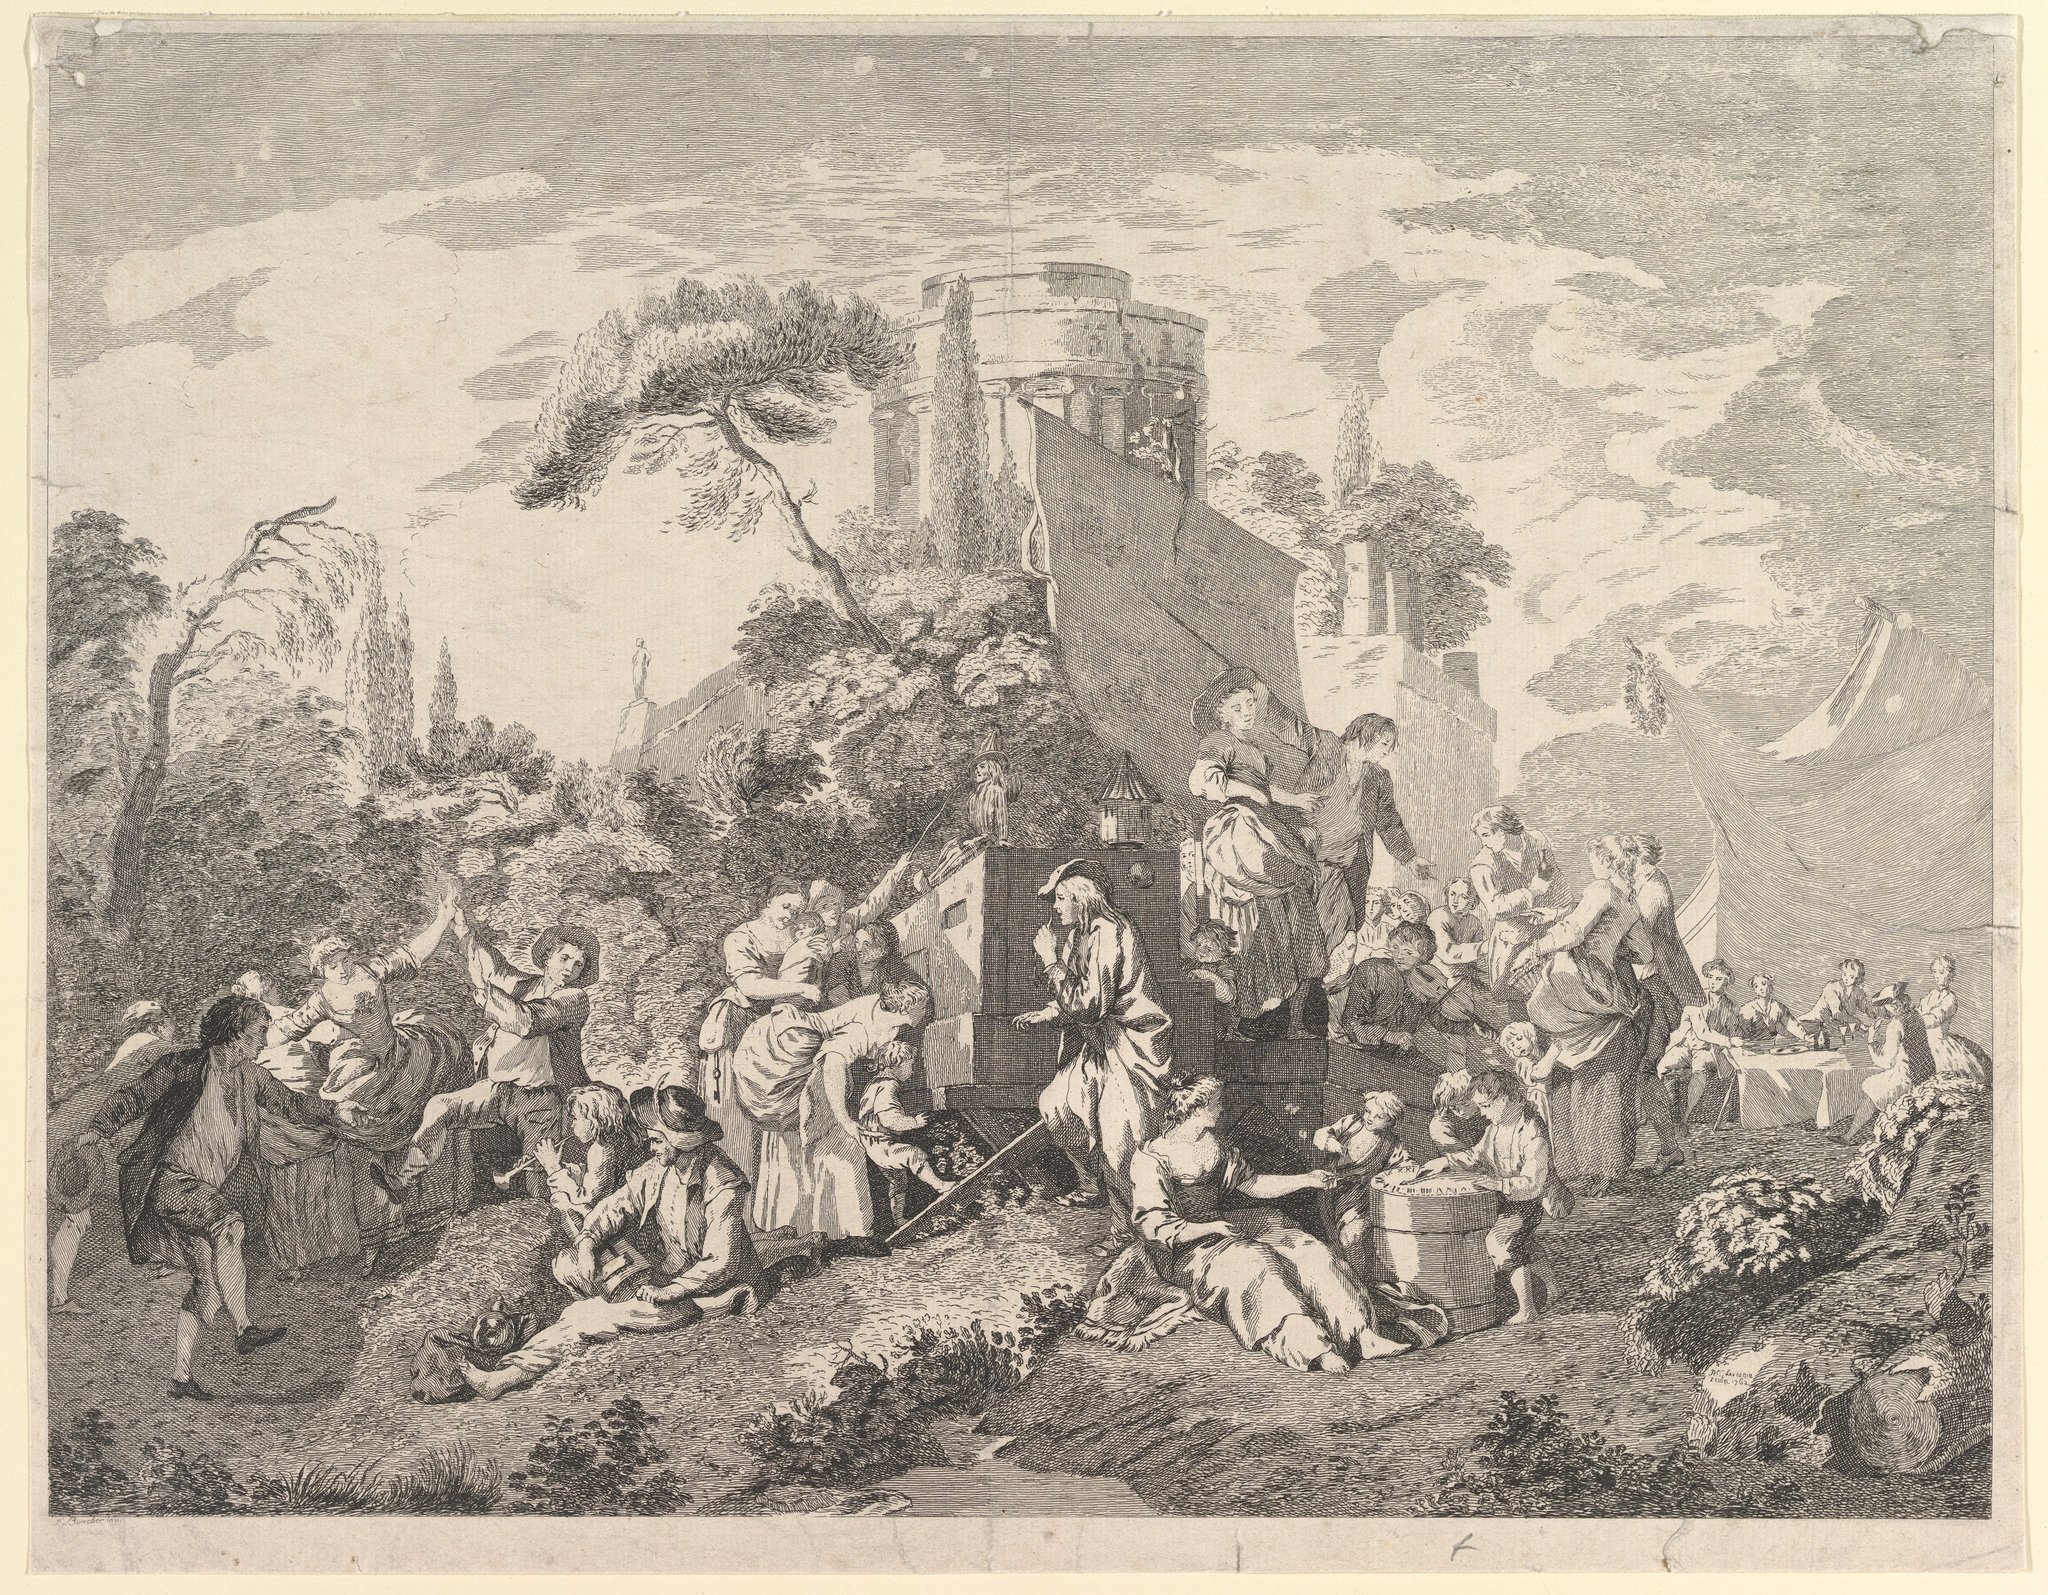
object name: print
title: Country Fair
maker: pierre charles lévesque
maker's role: artist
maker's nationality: french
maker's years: 1736-1812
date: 1762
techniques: etching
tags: children,men,women,daily life